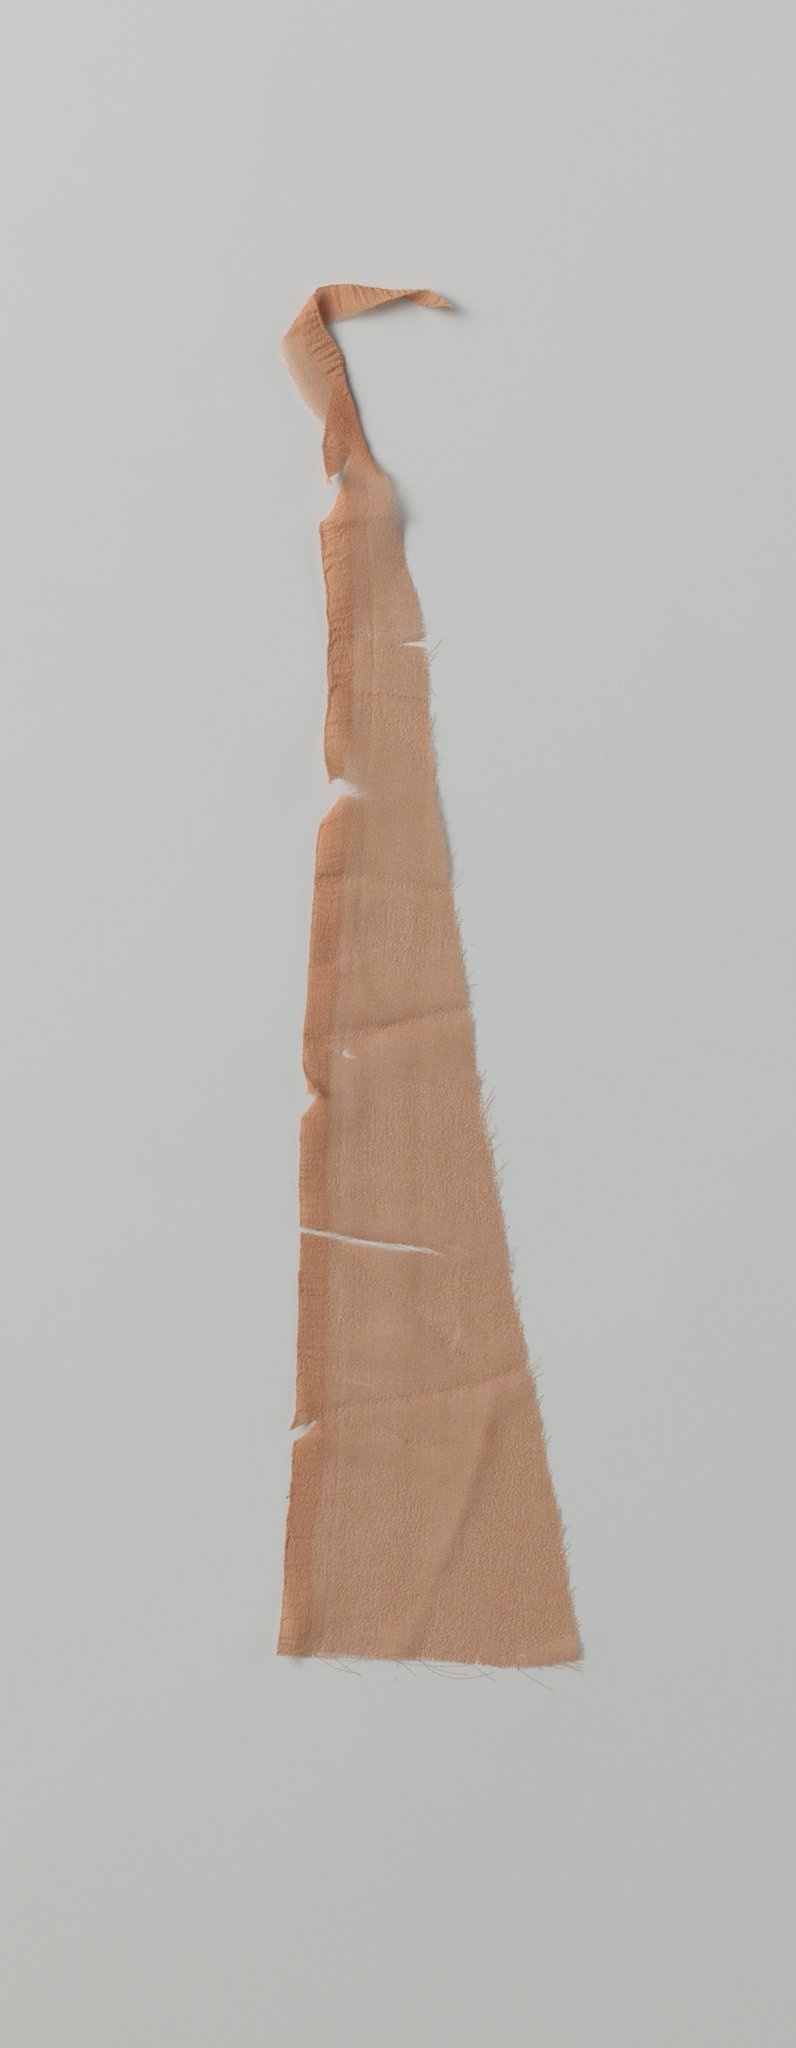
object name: silk textile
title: Fragment oranje zijdeweefsel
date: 1400-1950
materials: silk